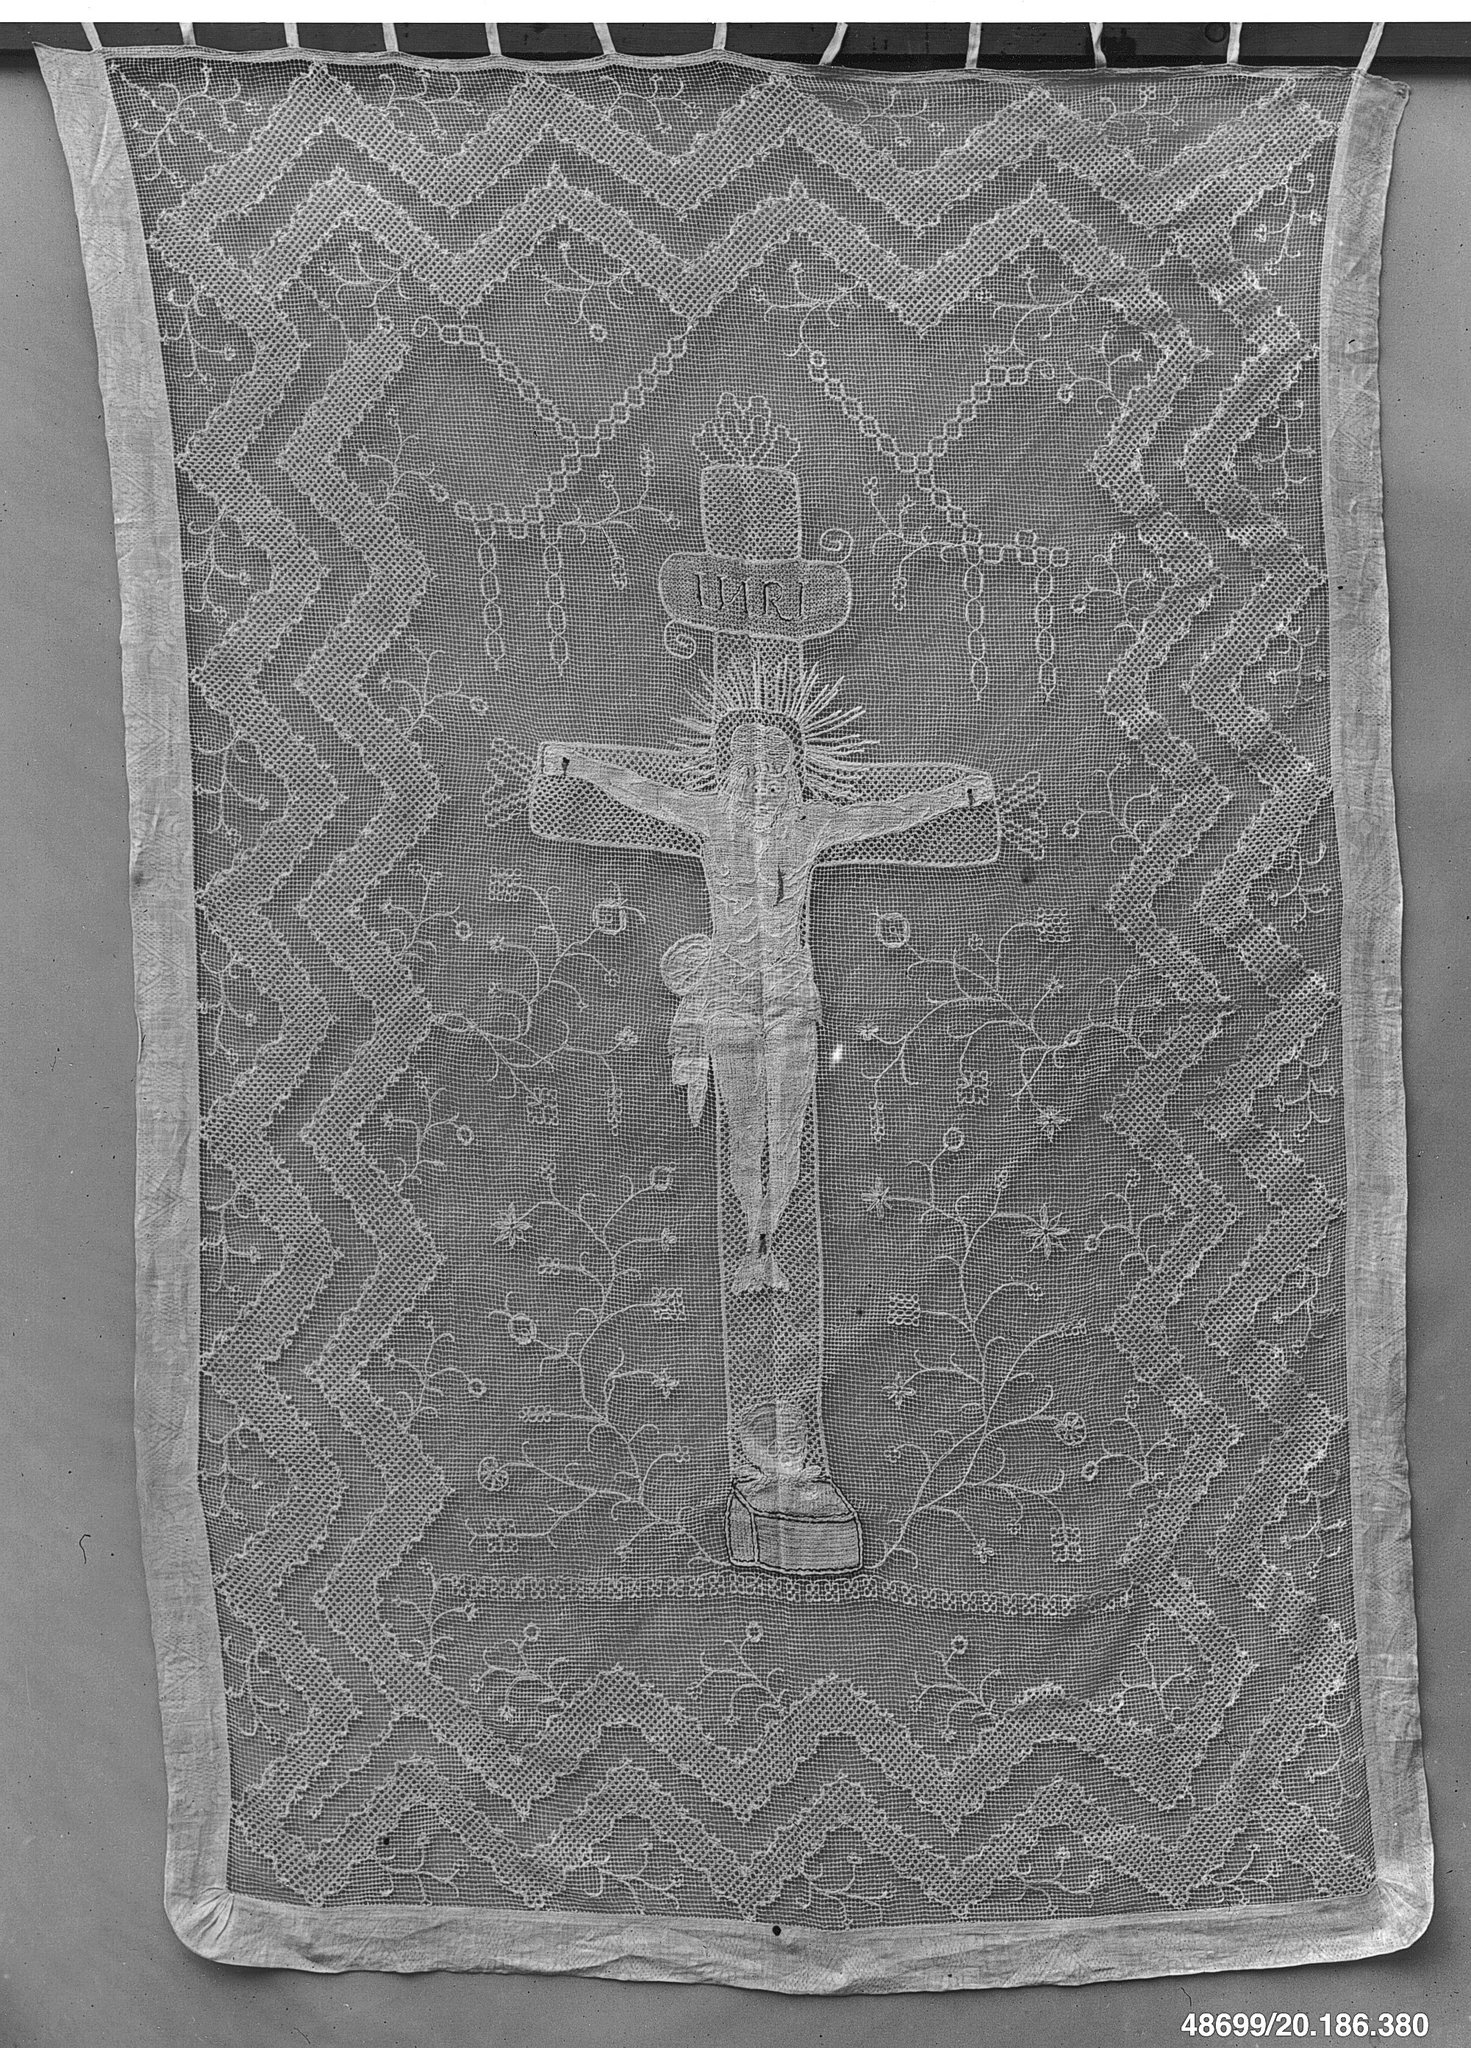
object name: hanging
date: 1601-1700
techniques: embroidery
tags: christ,crucifixion